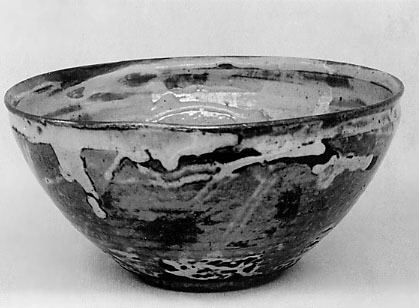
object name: teabowl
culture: japanese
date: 1801-1900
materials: clay, glaze